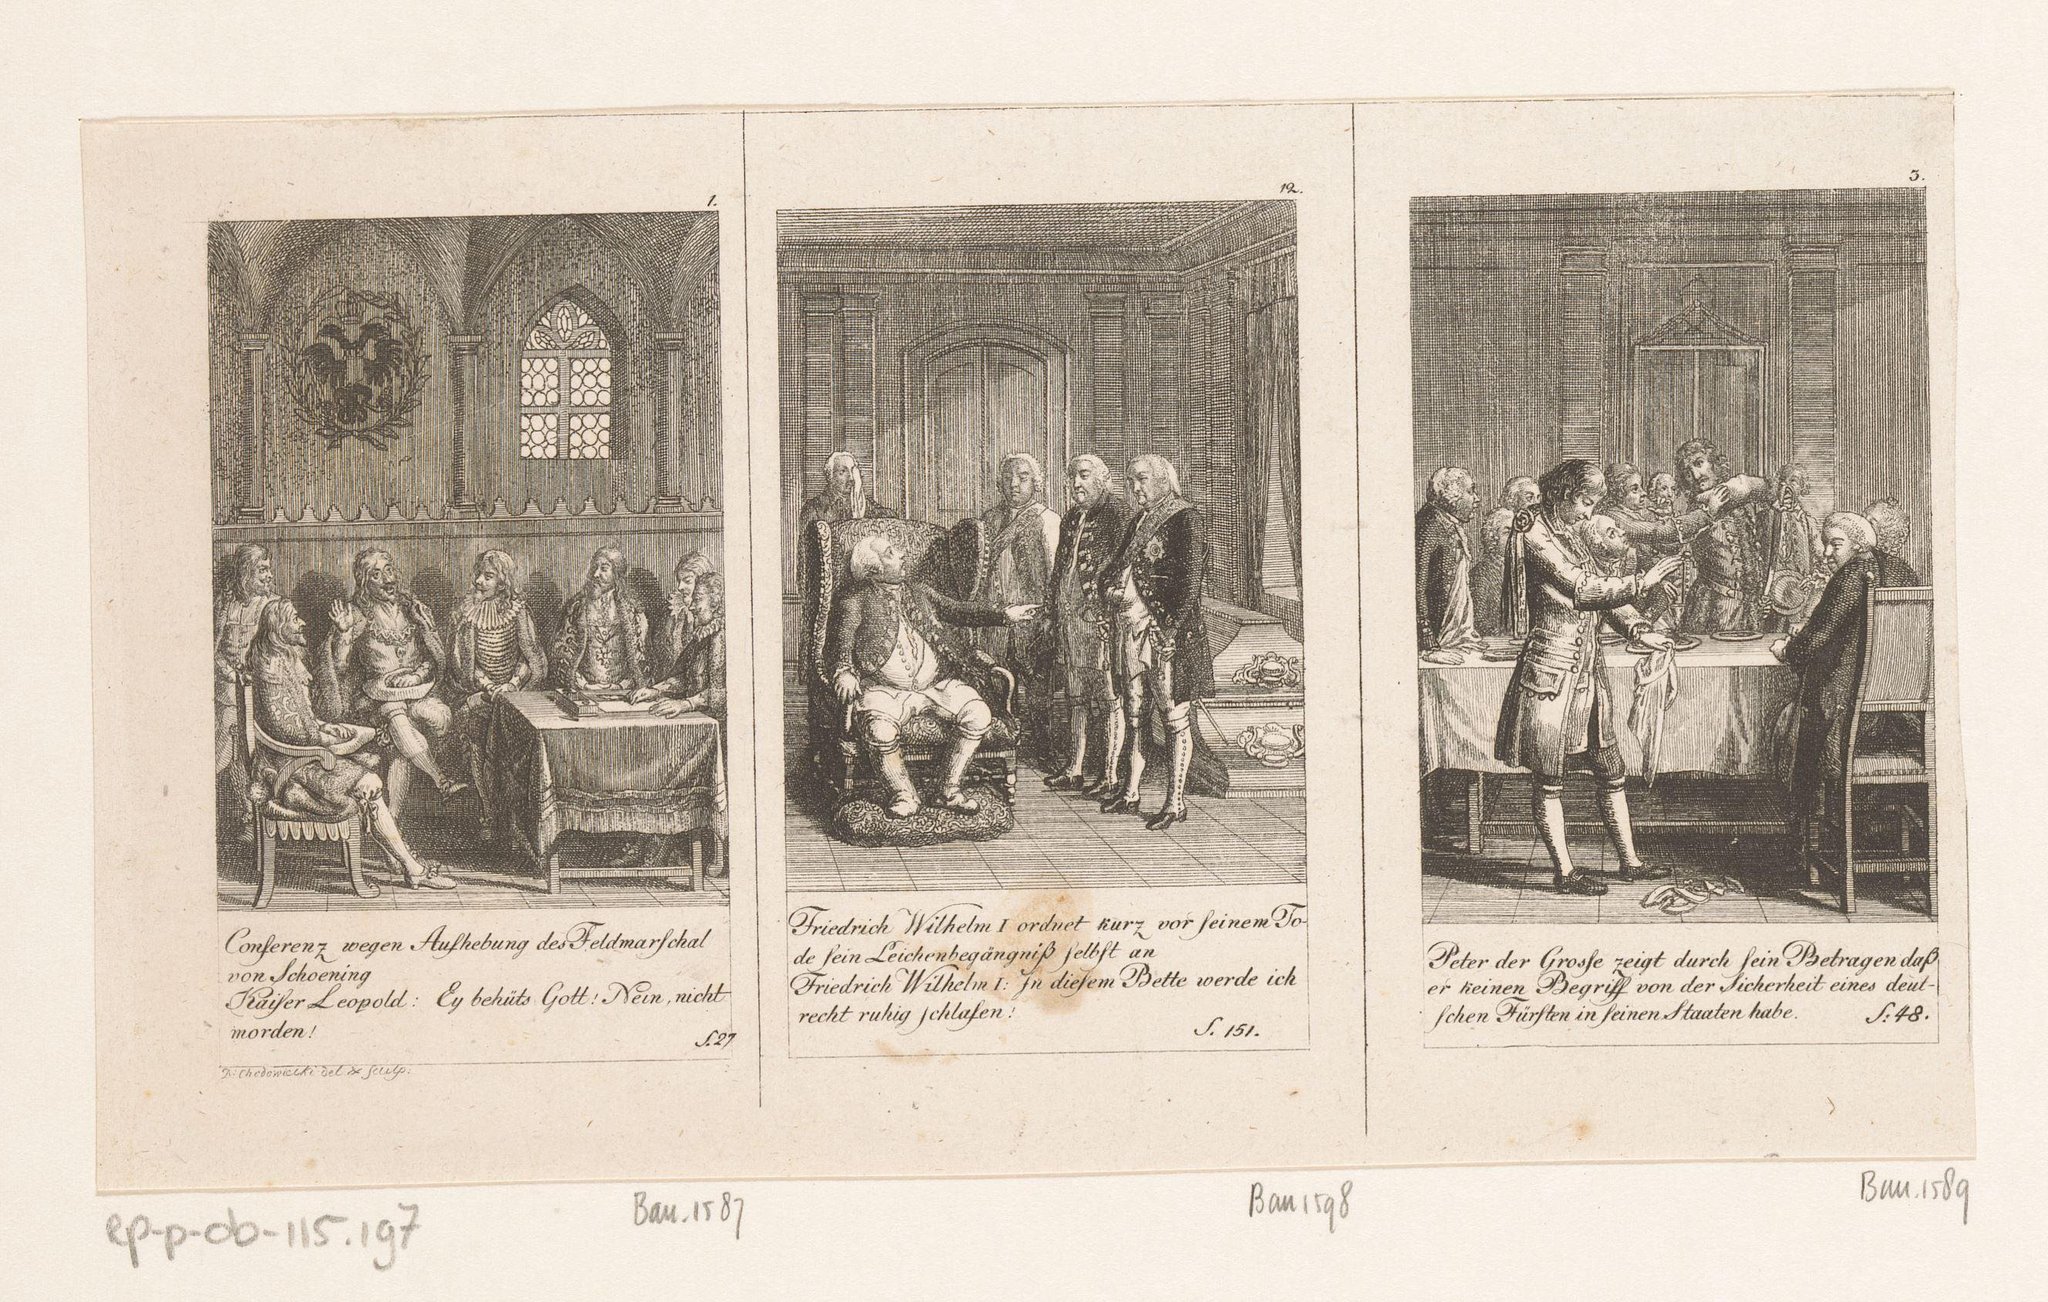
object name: print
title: Drie voorstellingen uit de Brandenburgse geschiedenis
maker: daniel nikolaus chodowiecki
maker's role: draughtsman, print maker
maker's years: 1726-1801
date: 1792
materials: paper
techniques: etching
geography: berlin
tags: peter i de grote (tsaar van rusland), leopold i (keizer van duitsland), double-headed eagle, history, deathbed, coffin, ruler, sovereign, banquet of elegant company, negotiations, conference ~ diplomacy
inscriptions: collector's mark: Lugt 2228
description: Prenten gebruikt voor: Historisch Genealogischer Calender auf das jahr 1793. Berlijn: Königl. Academie der Wissenschaften, [1792].